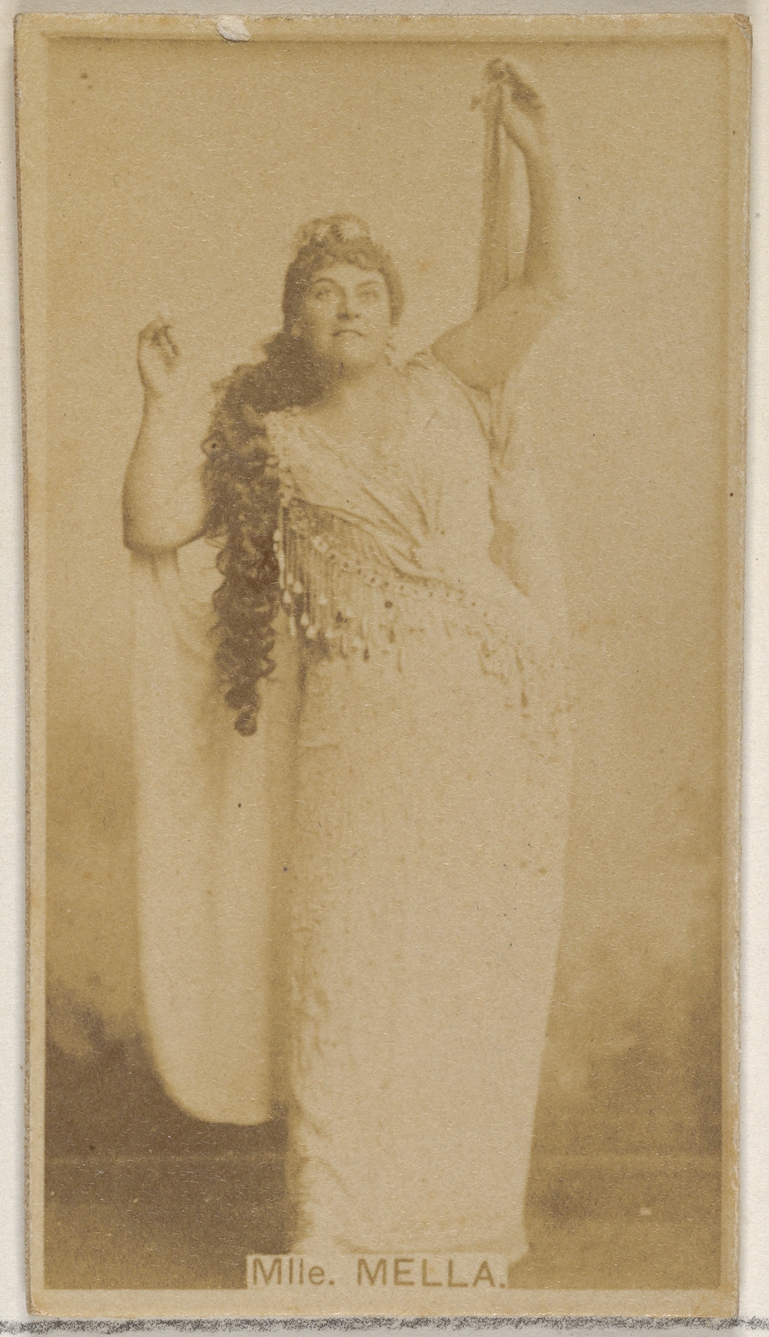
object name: photograph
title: Mlle. Mella, from the Actors and Actresses series (N45, Type 8) for Virginia Brights Cigarettes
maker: allen & ginter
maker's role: publisher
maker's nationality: american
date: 1888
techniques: albumen silver print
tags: portraits,women,actresses